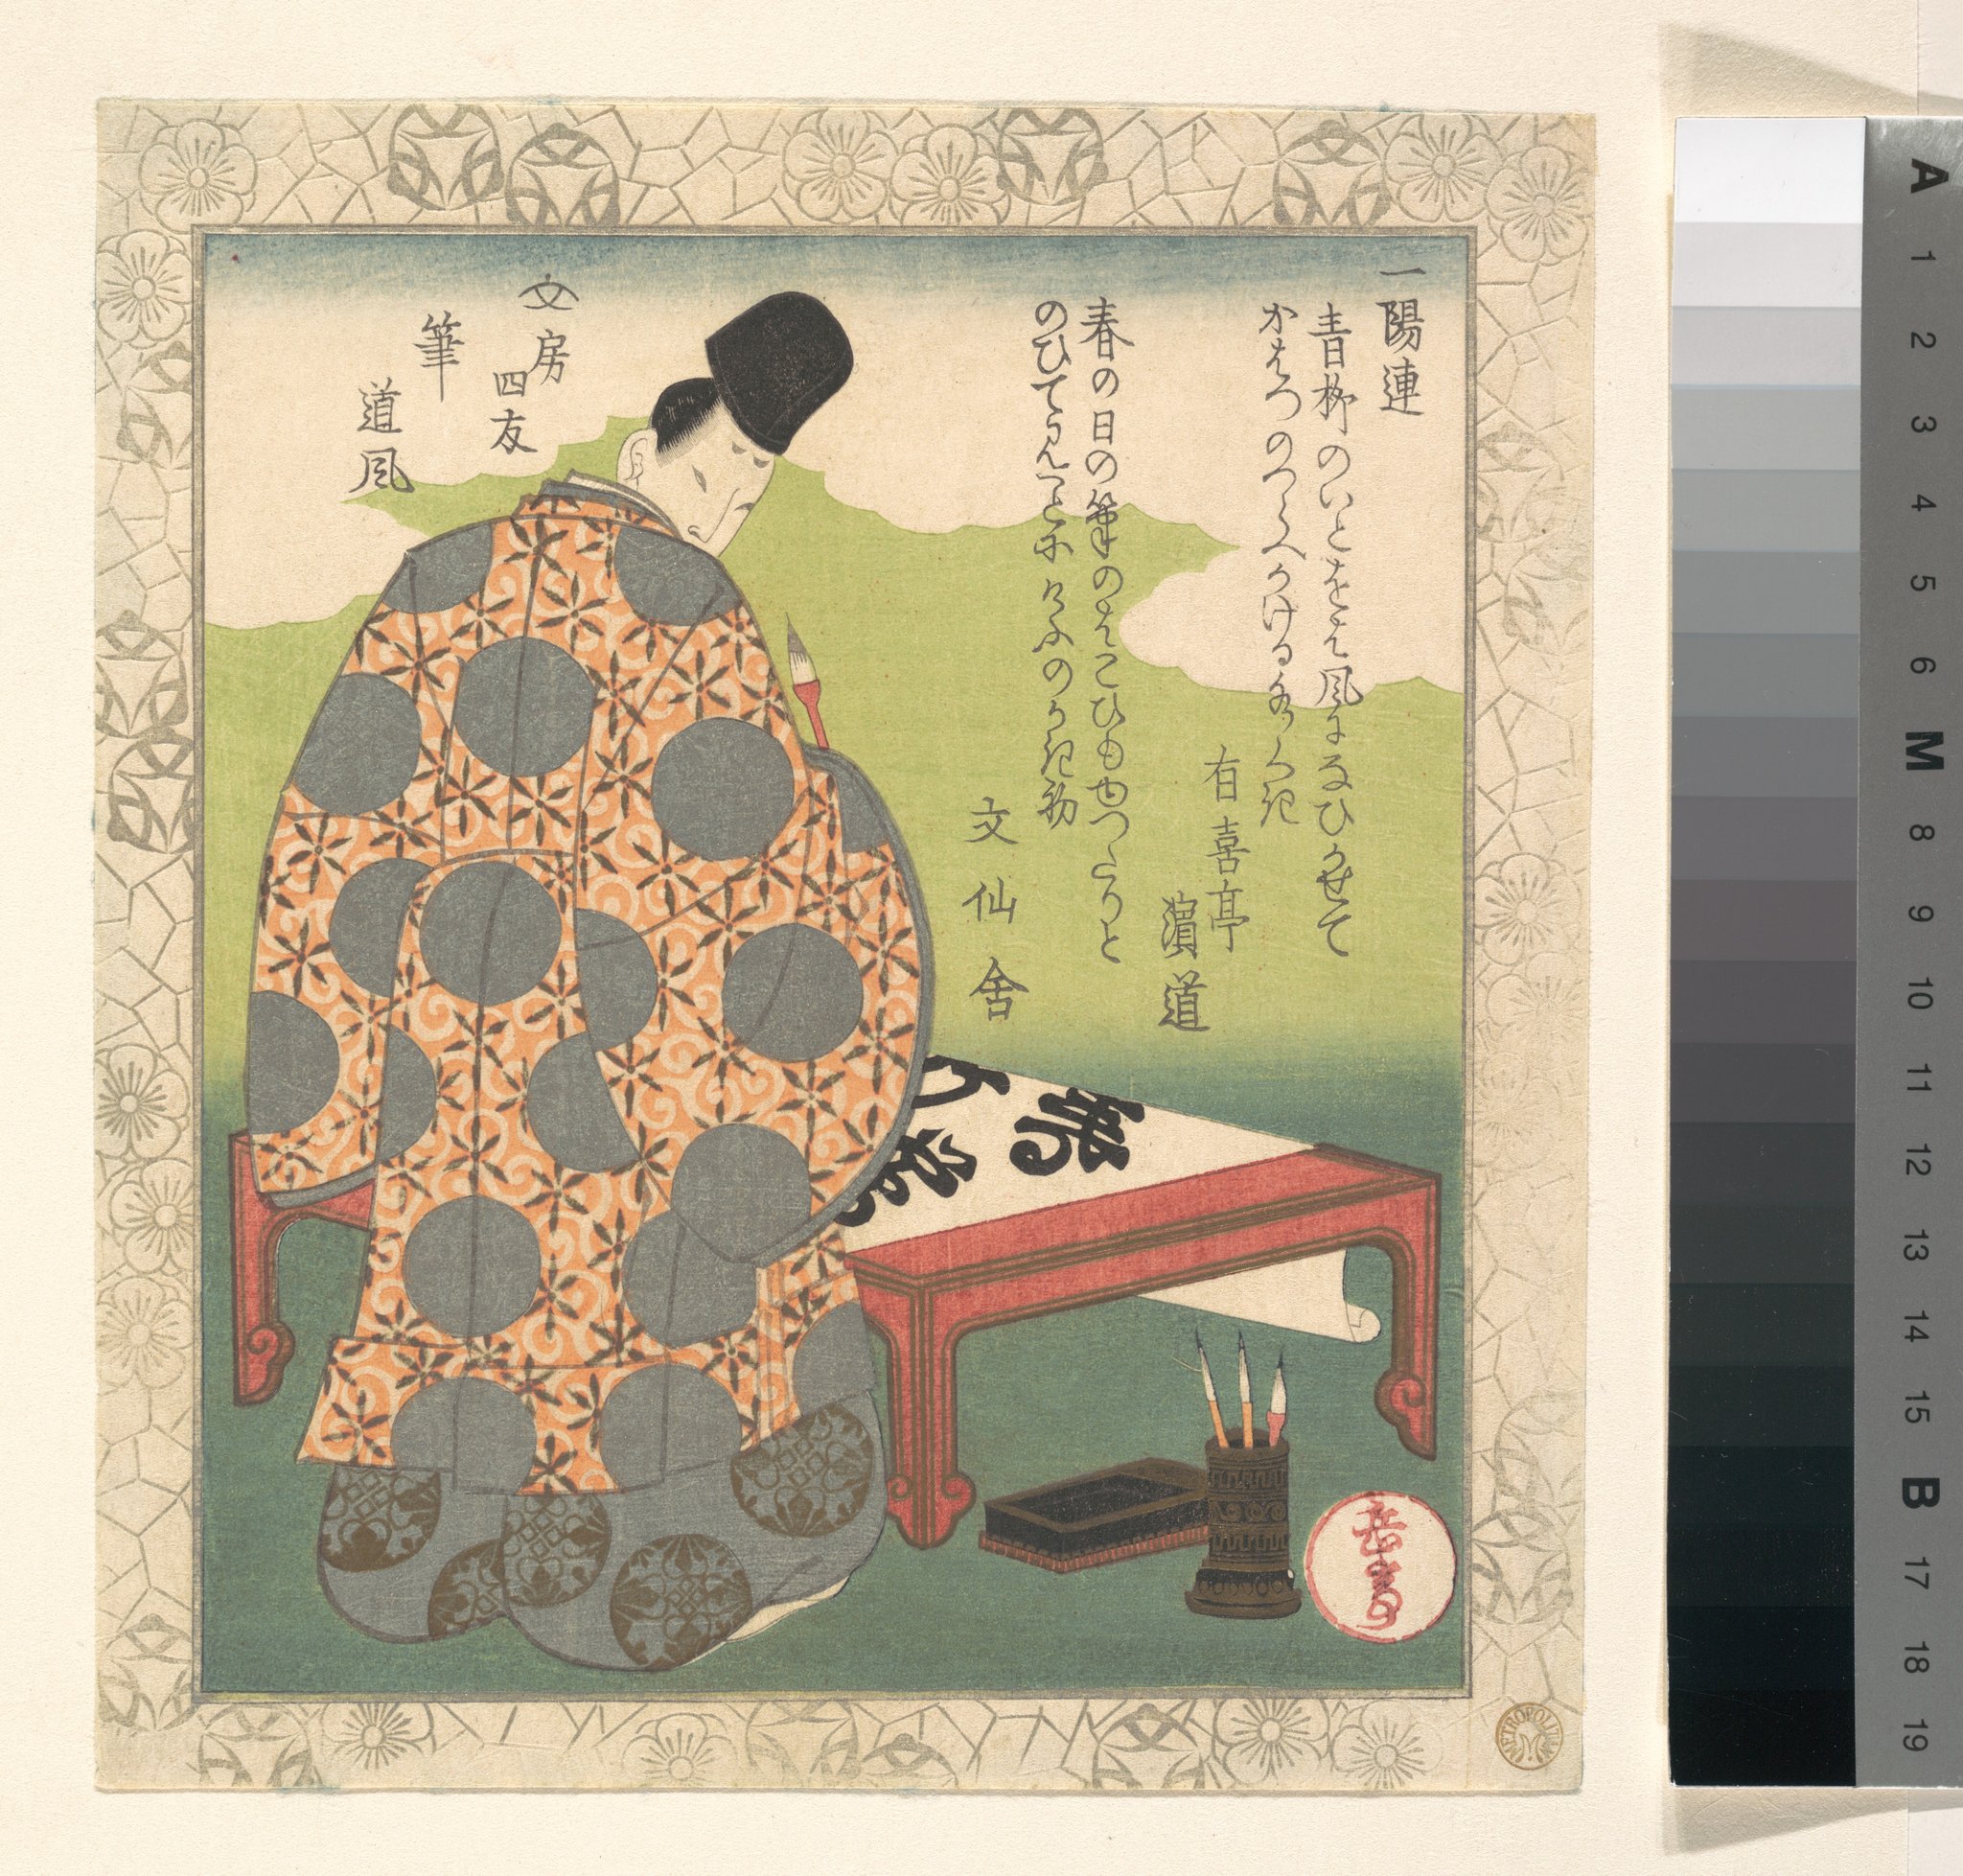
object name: print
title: Nobleman Making Calligraphy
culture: japanese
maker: yashima gakutei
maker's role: artist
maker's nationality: japanese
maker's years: 1786-1868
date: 1830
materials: ink, paper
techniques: surimono, woodblock print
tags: men,writing,calligraphy